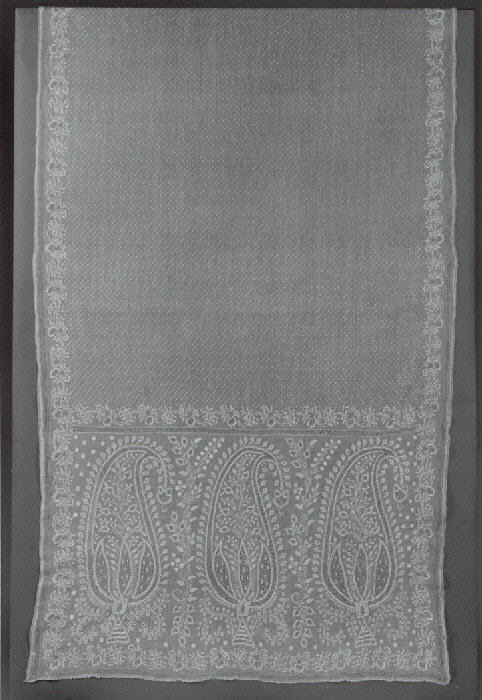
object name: shawl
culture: american or european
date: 1801-1825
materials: cotton